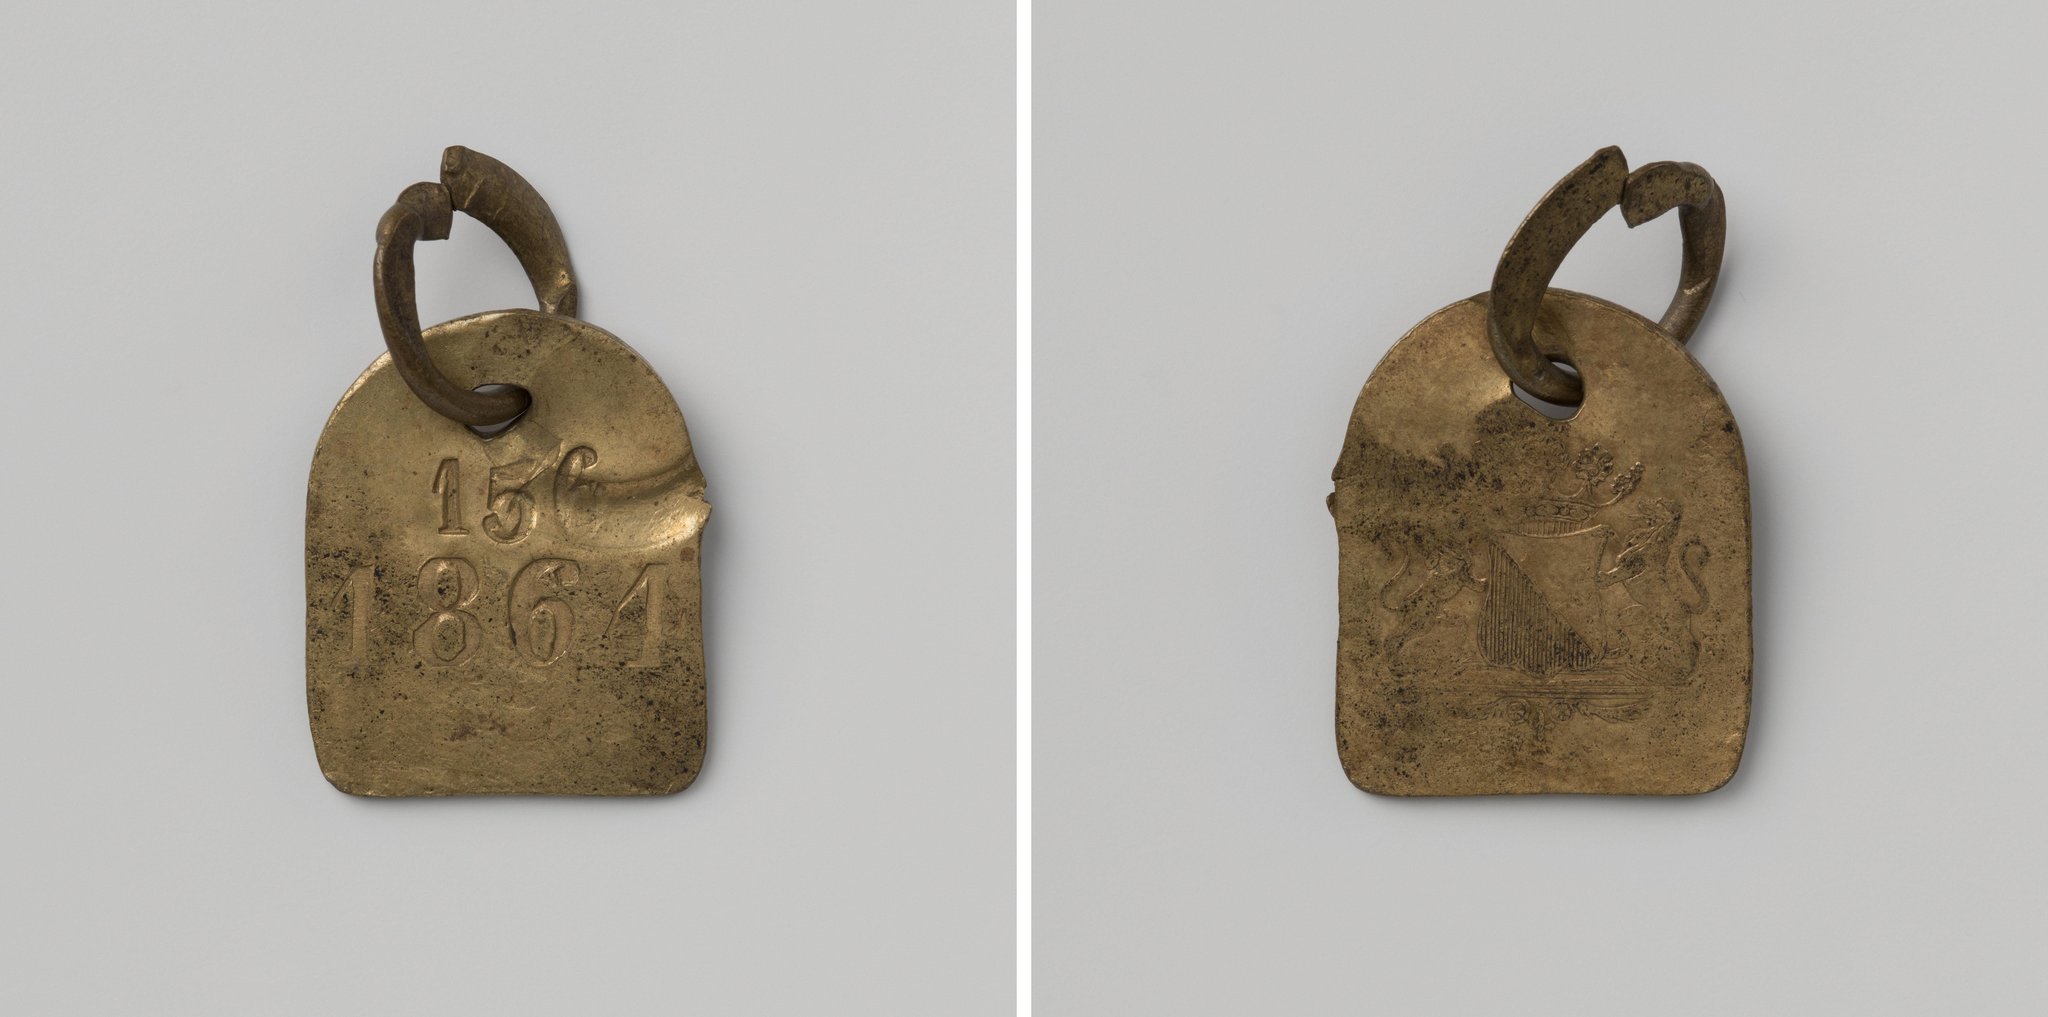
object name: hondenbelastingloodje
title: Stad Utrecht, loodje met AA en no. 494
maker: Anonymous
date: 1858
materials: lead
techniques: striking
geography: utrecht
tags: utrecht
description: loodje met gat erin. Voorzijde: letters AA en cijfer 494 boven jaartal. Keerzijde: gekroond wapenschild, geflankeerd door twee leeuwen